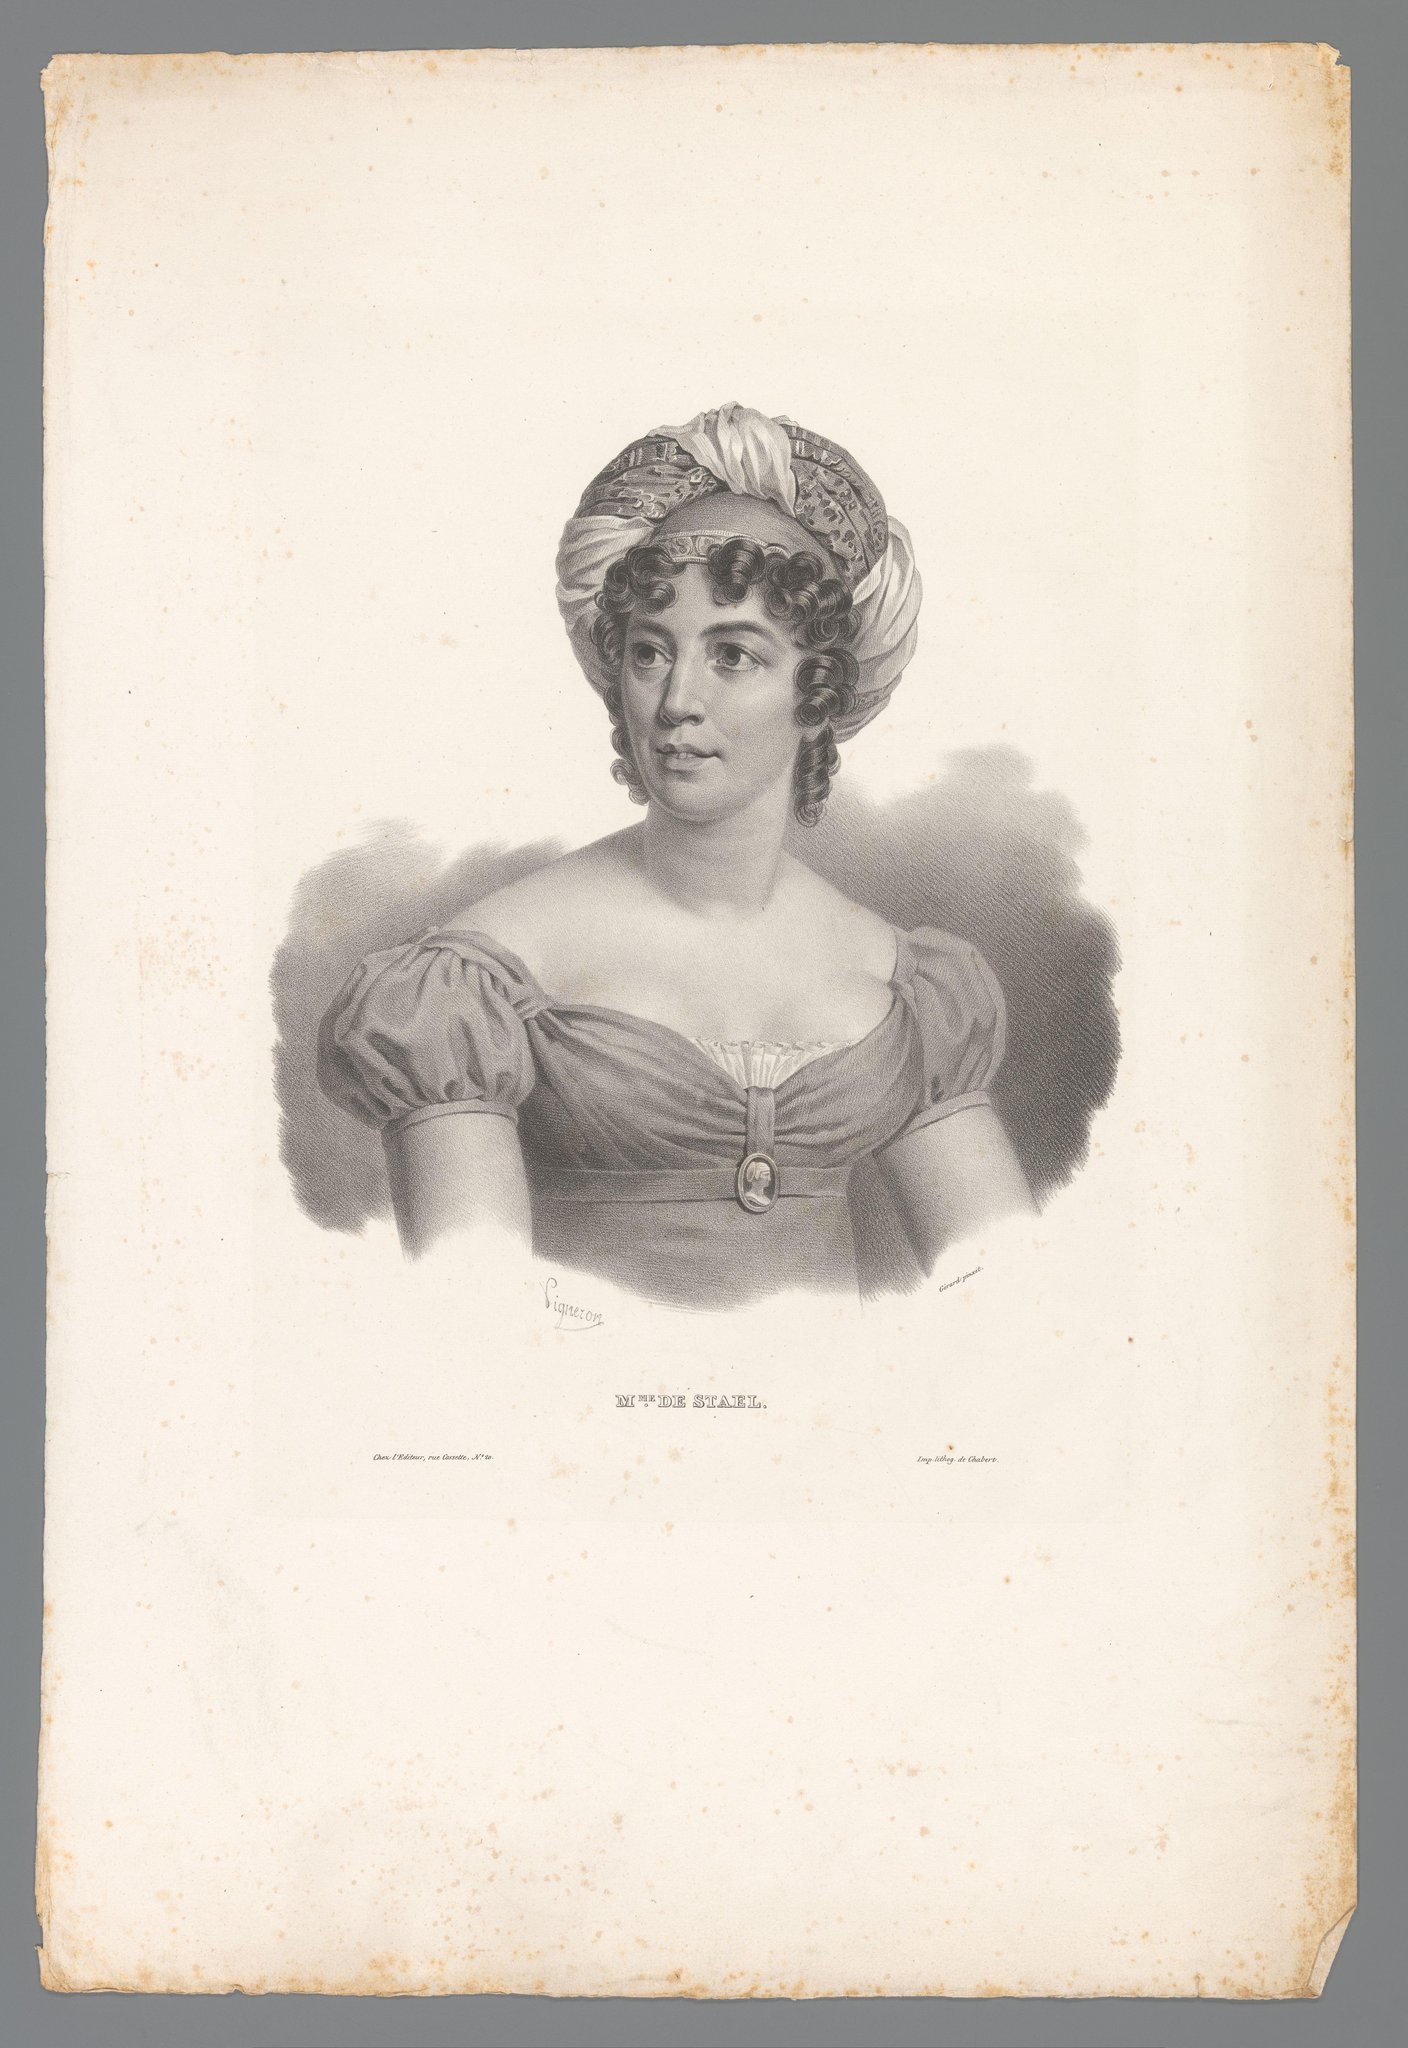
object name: print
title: Portret van de schrijfster Germaine de Staël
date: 1827-1854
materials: paper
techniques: lithograph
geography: paris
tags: historical persons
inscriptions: collector's mark: Lugt 2228